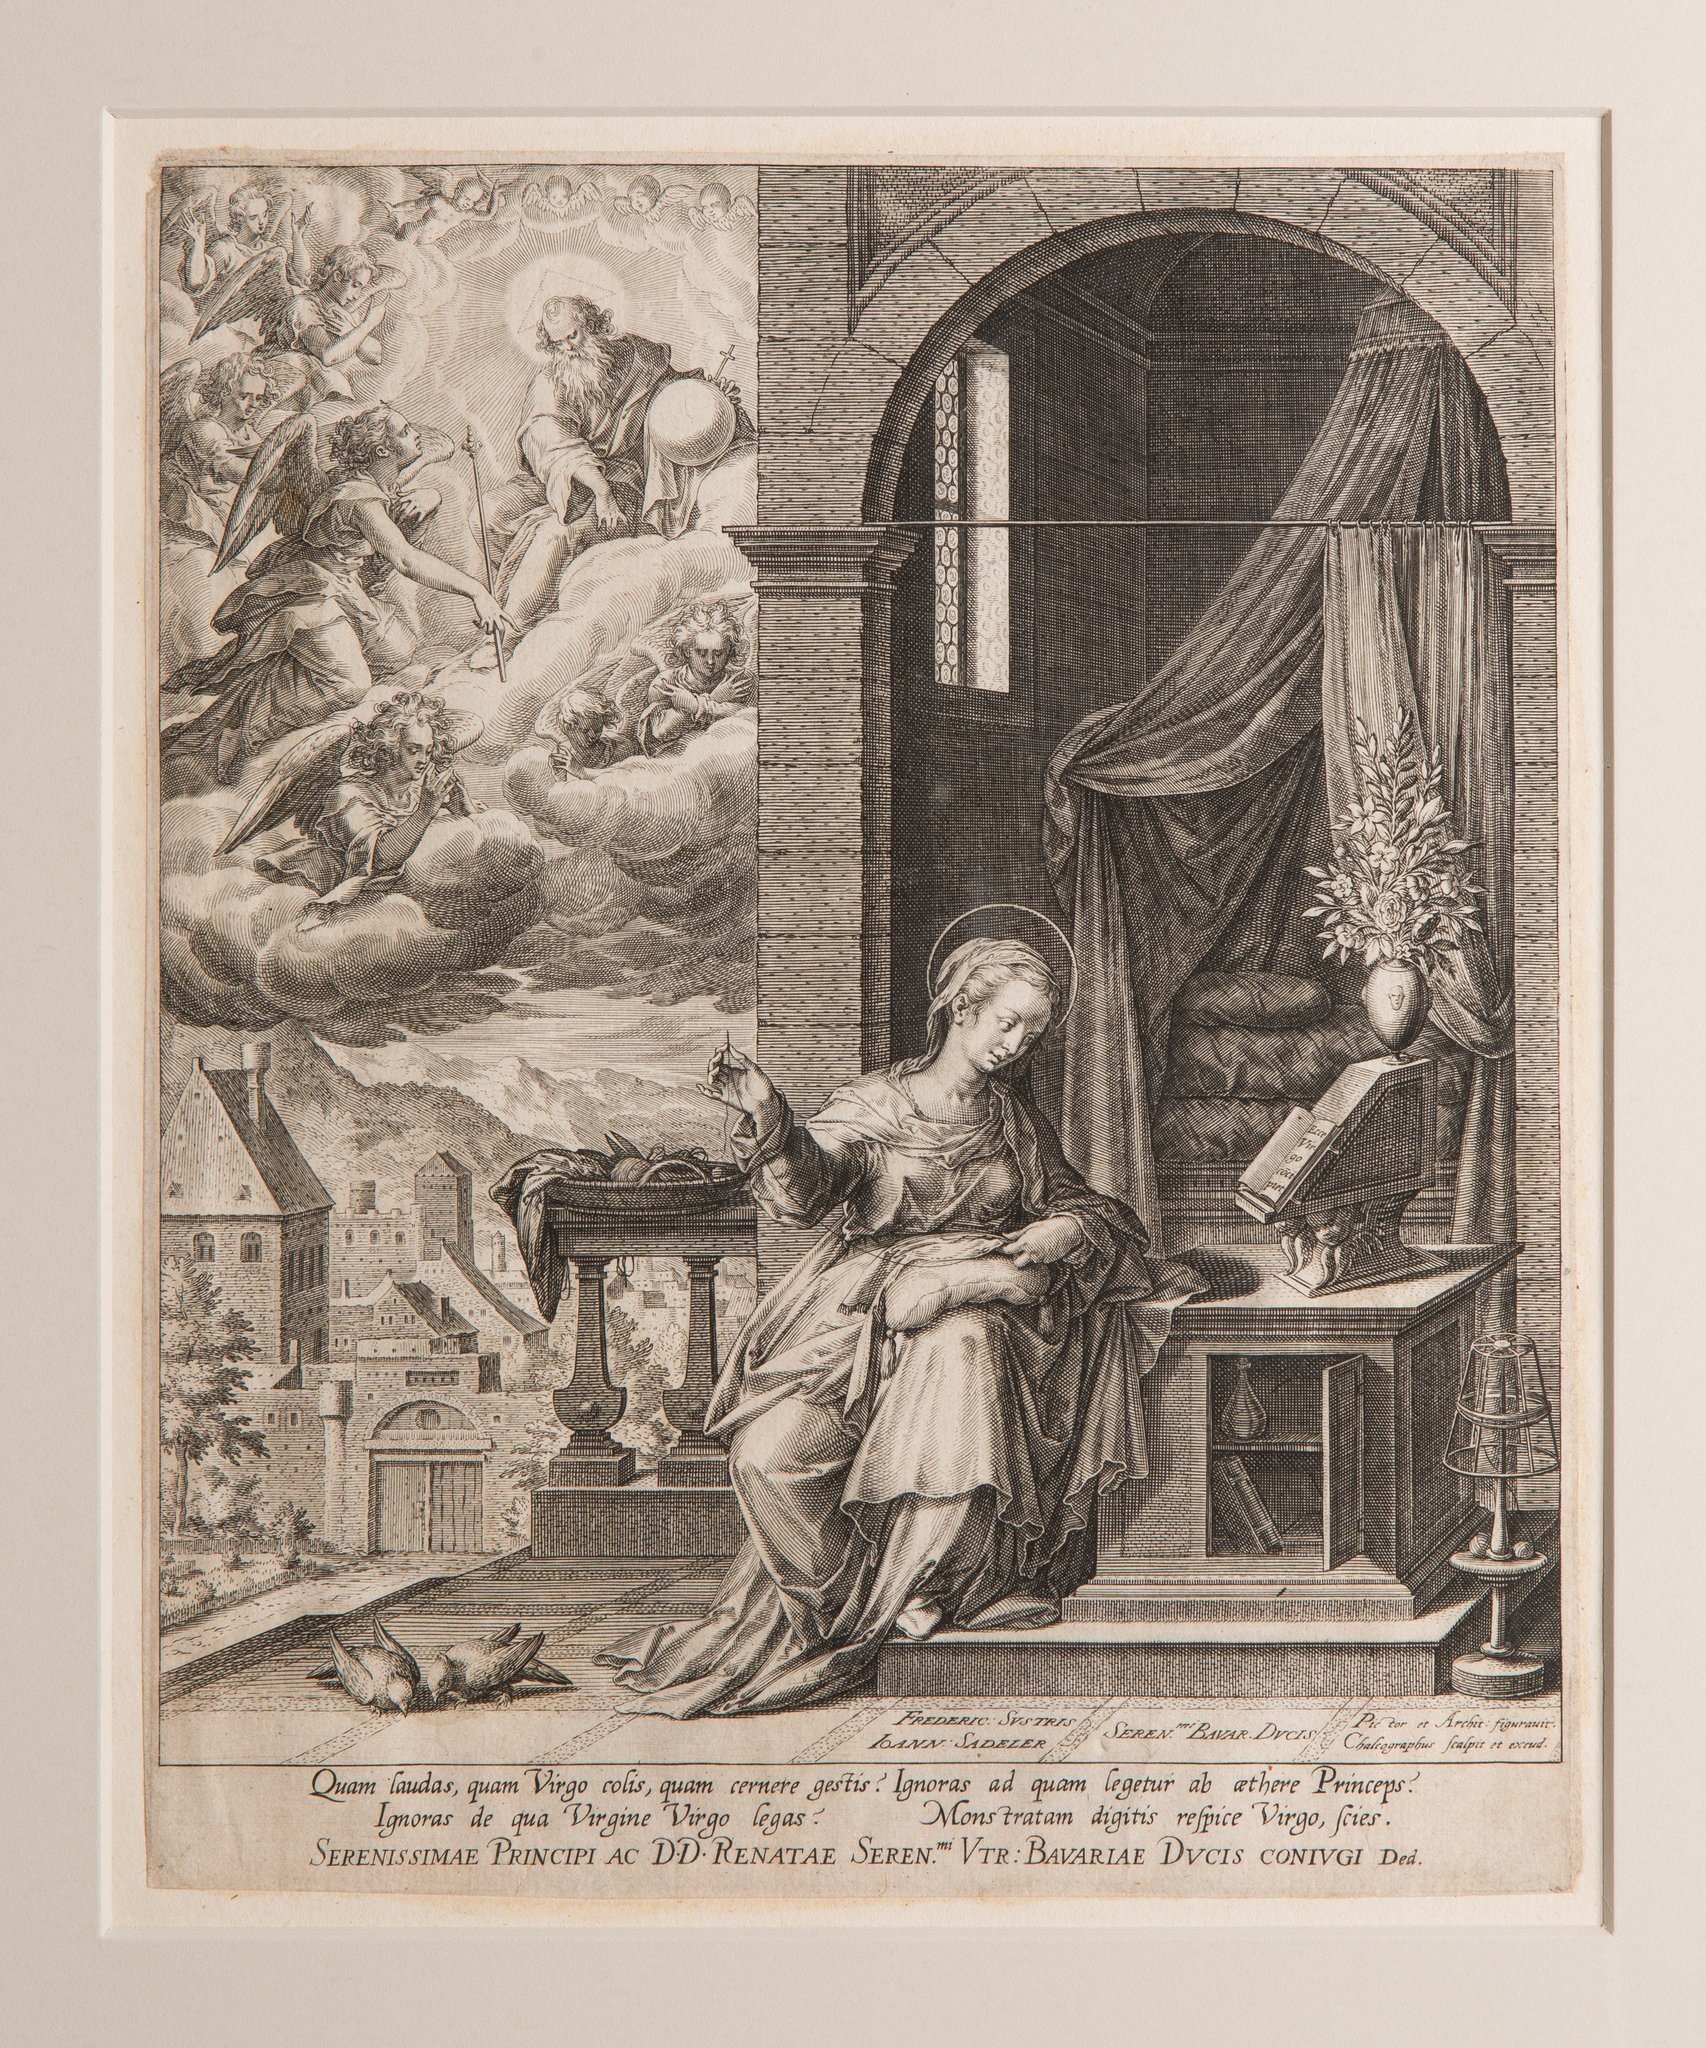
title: God Sending the Archangel Gabriel to the Virgin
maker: johann sadeler (i)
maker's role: artist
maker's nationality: netherlandish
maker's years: 1550-1601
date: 1595-1600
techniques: engraving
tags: virgin mary,archangel gabriel,beds,sewing